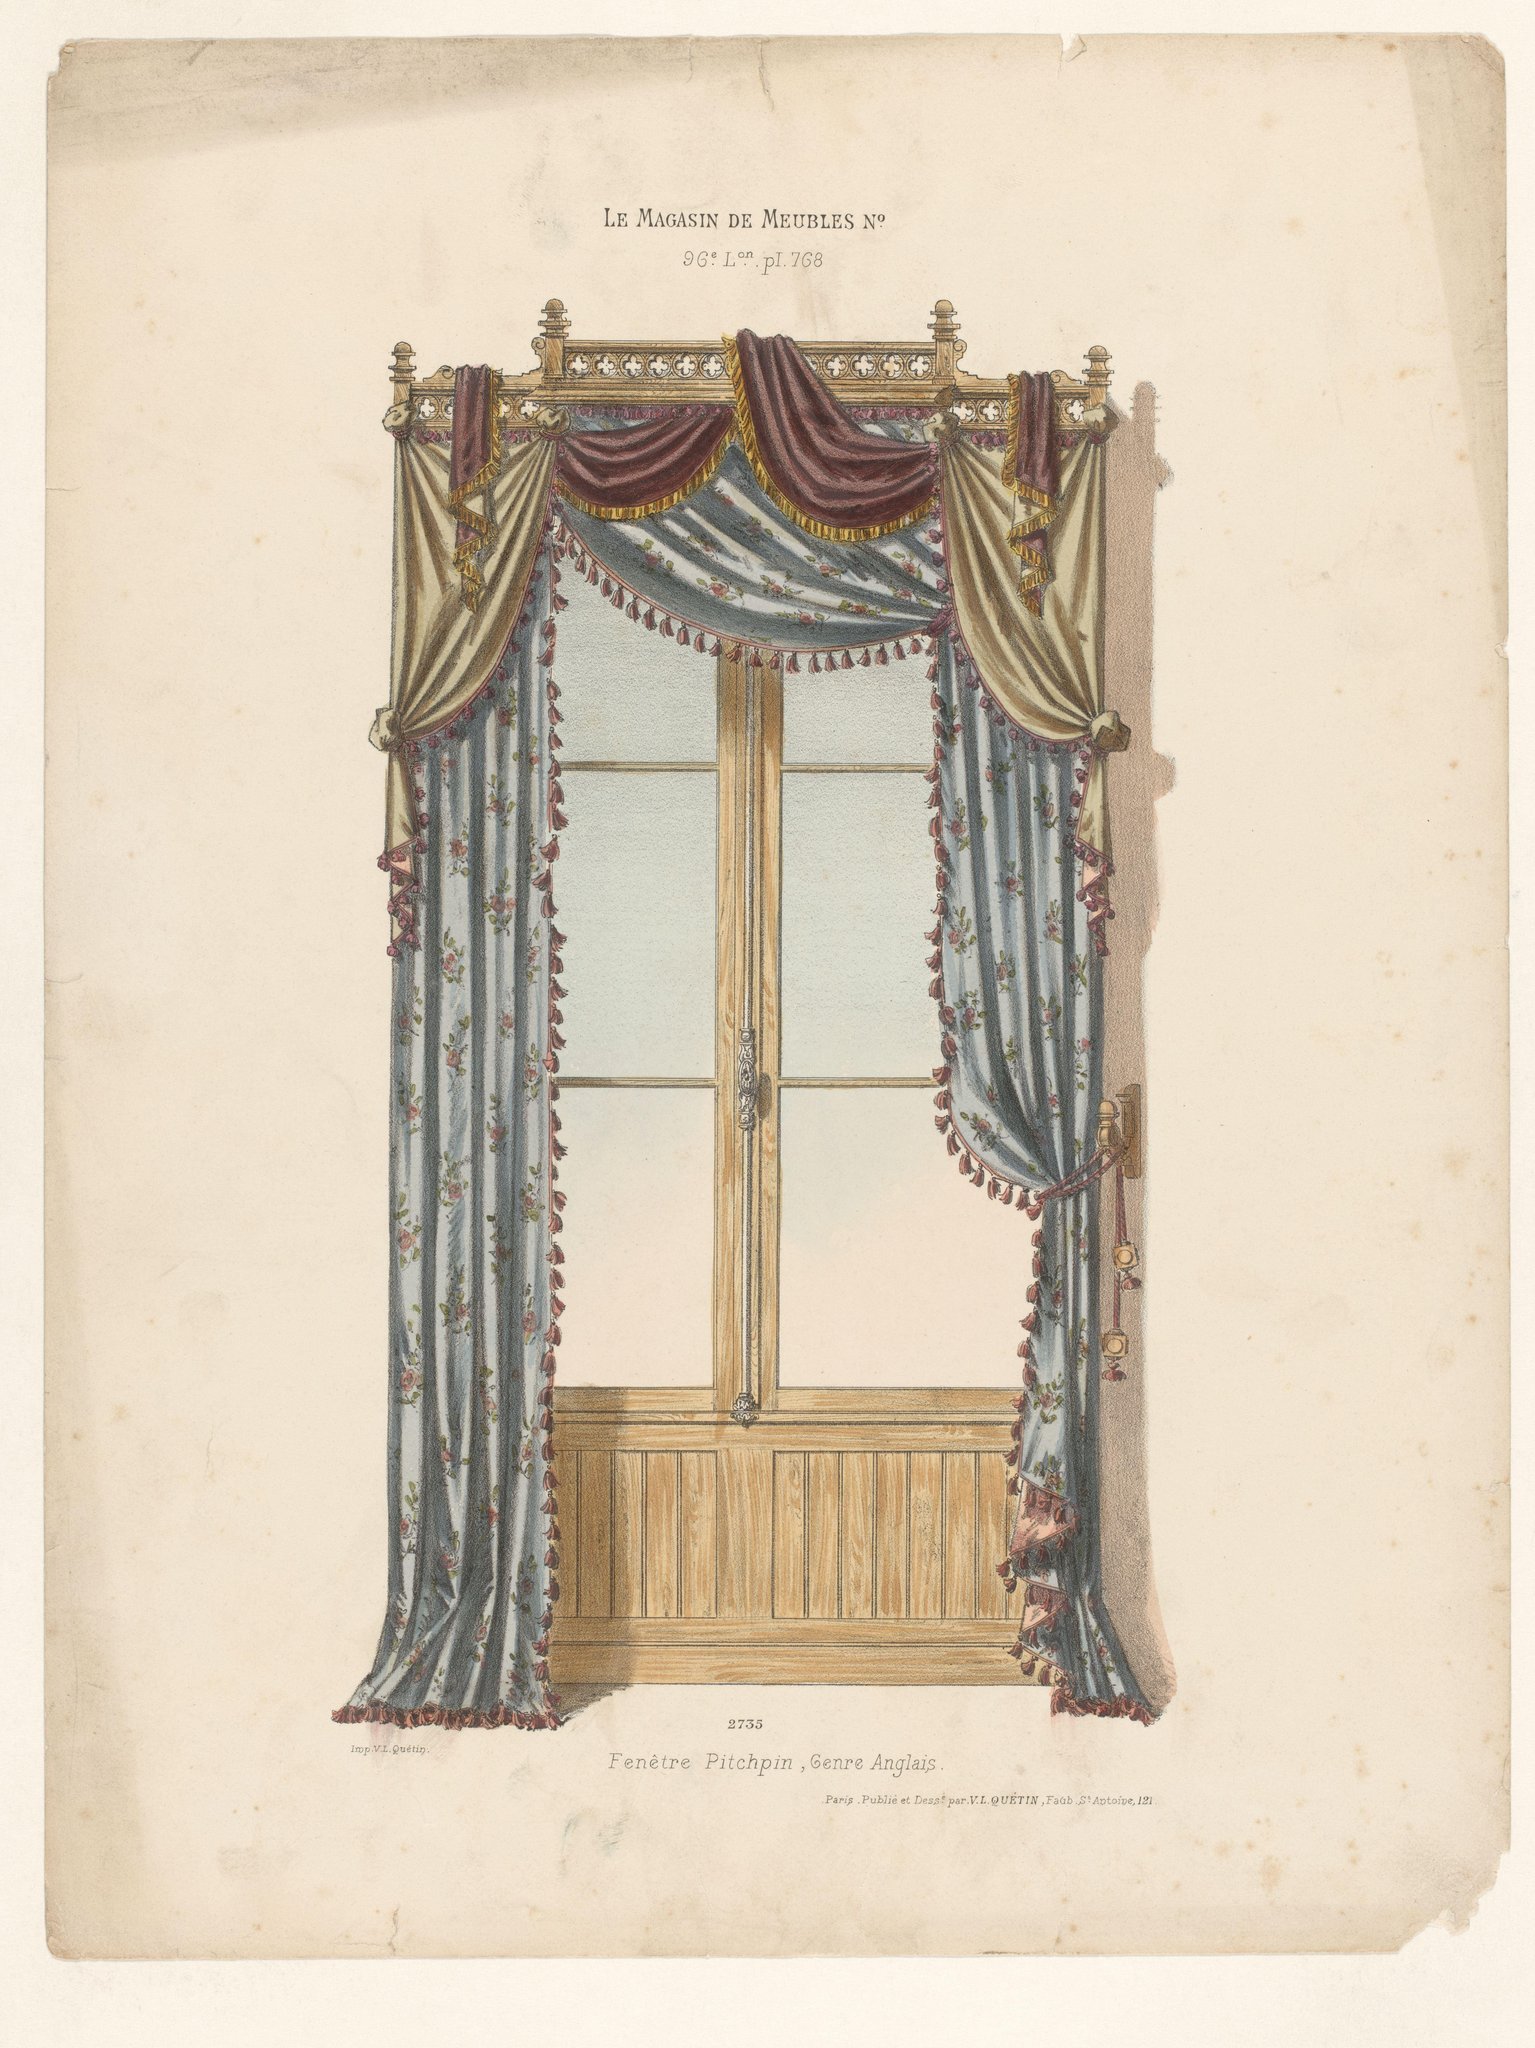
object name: print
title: Le Magasin de Meubles No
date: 1878-1904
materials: paper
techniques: hand coloring, lithograph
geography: paris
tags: window, hangings and drapery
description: Een venster met gedrapeerde gordijnen. Prent uit 96e Livraison.